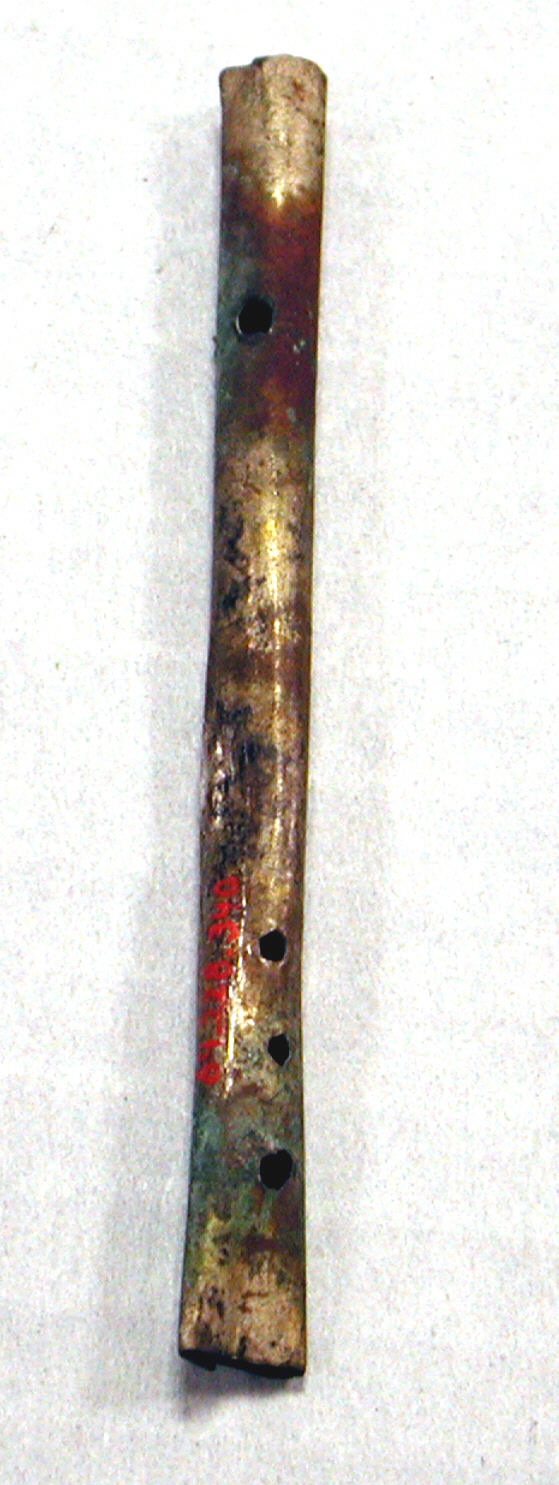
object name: flute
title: Hammered Silver Miniature Flute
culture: peruvian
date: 701-1566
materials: gilt, silver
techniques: hammering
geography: peru